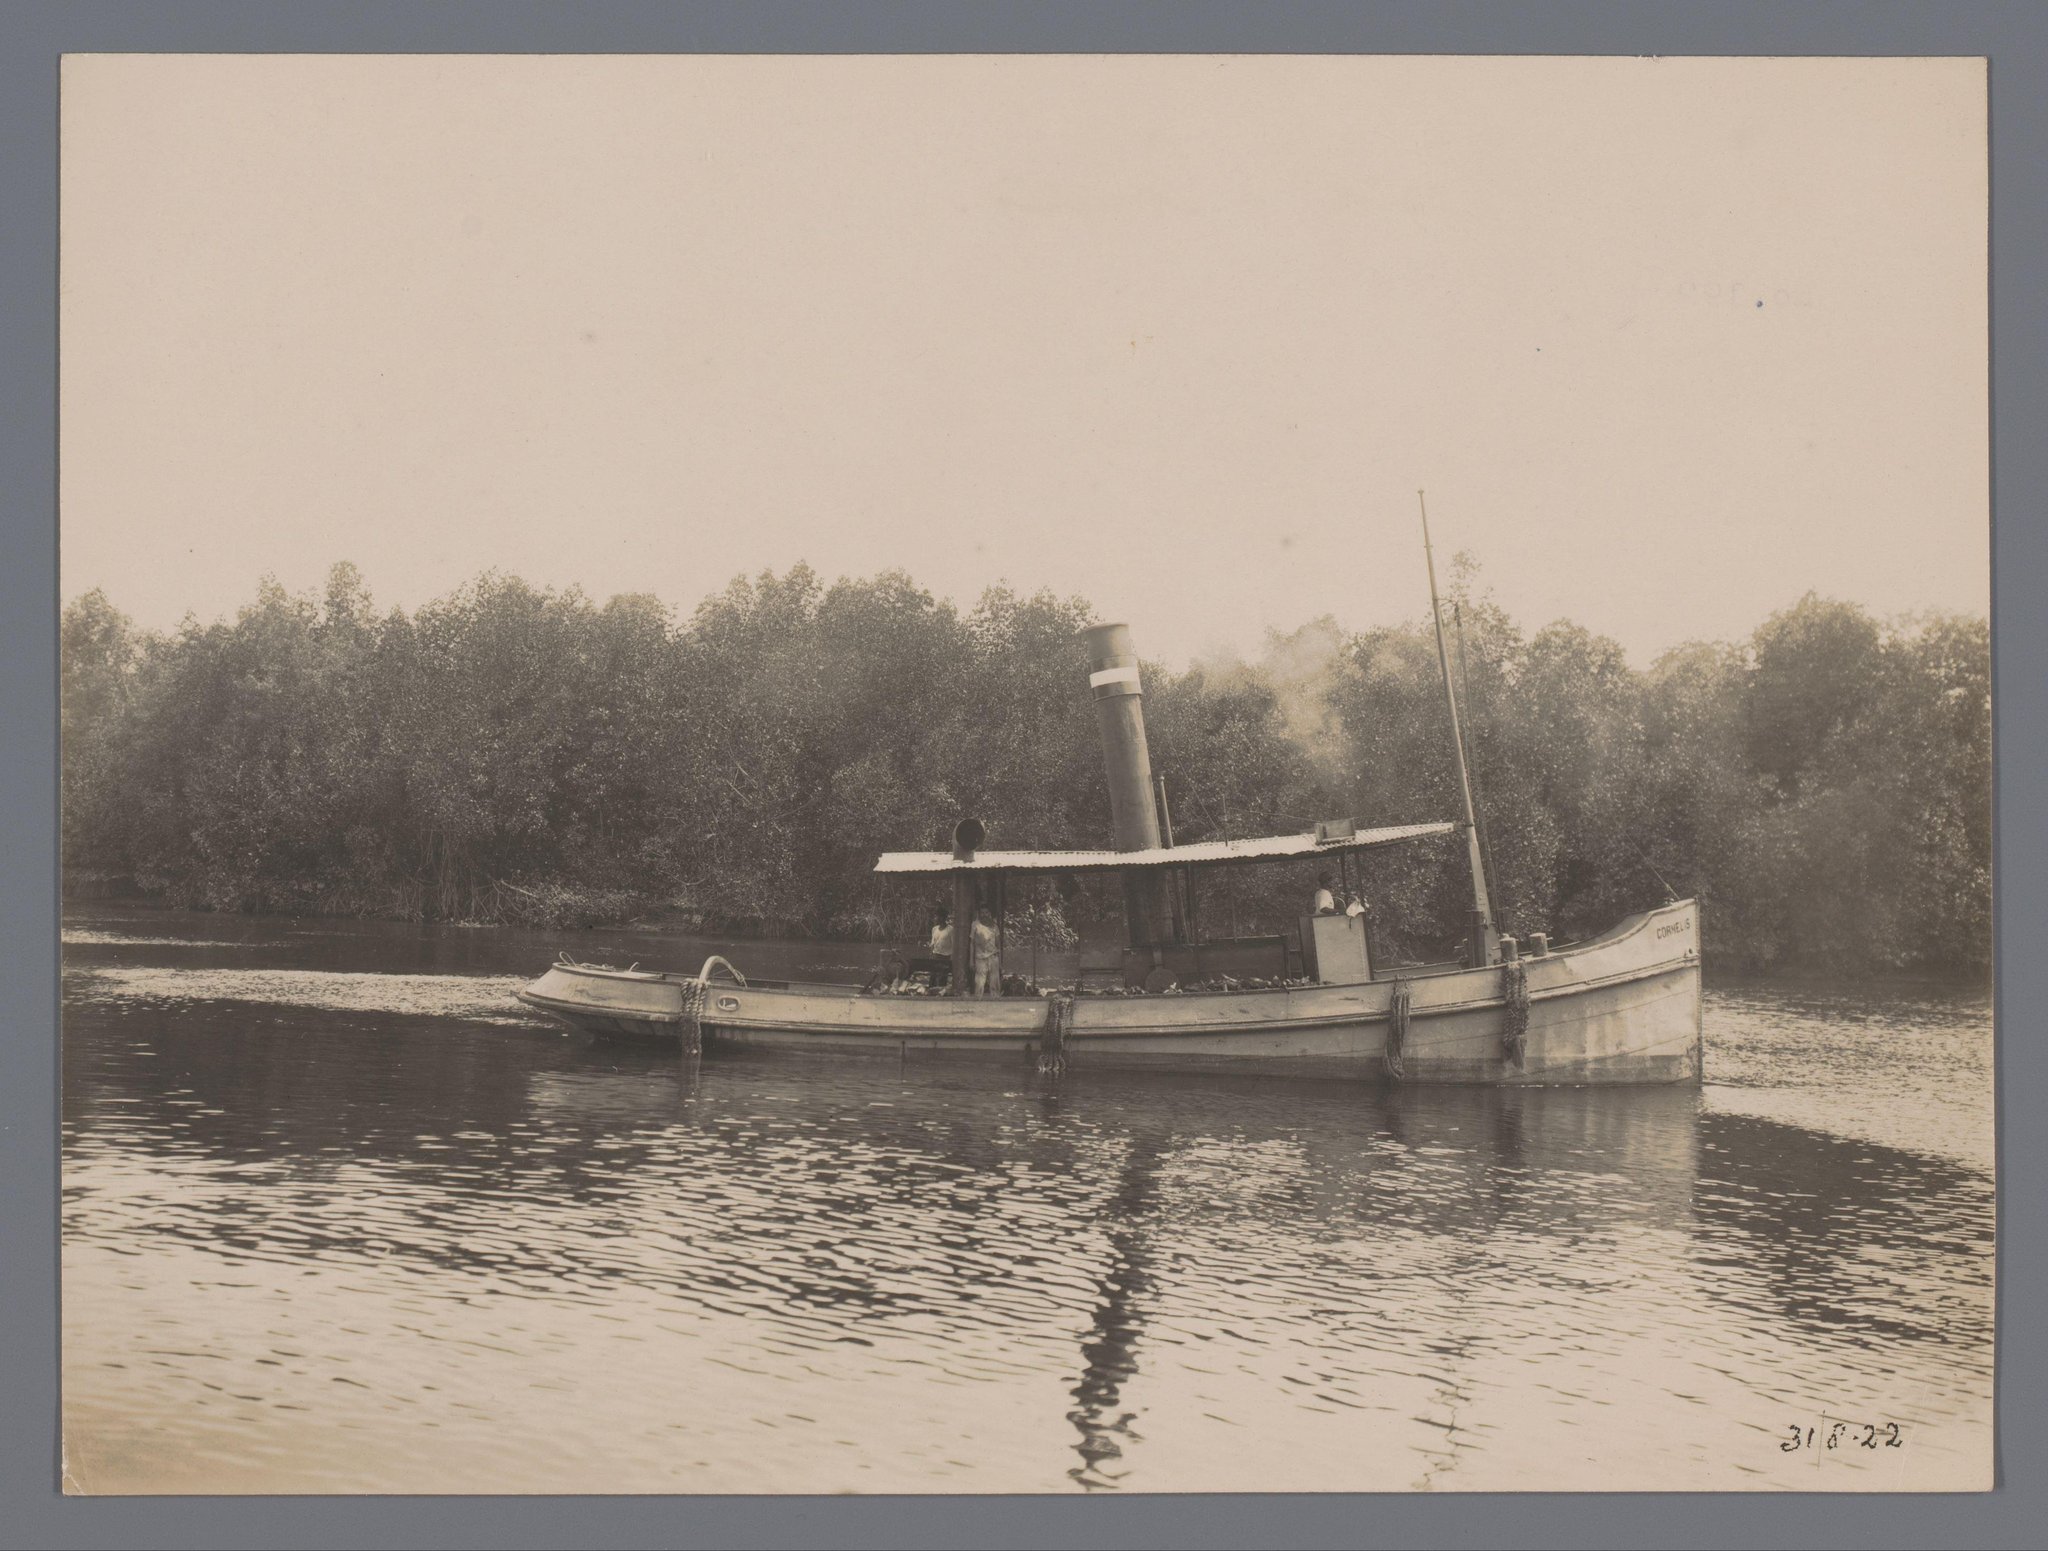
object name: photograph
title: Oceaanhaven Belawan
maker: Anonymous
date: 1922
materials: photographic support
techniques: gelatin silver print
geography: belawan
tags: harbour, building-site, tug, pusher tug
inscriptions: date: ‘31/8-22’, inscription: ‘No. 191 / Sleepboot "Cornelis"’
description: De sleepboot 'Cornelis'. Genummerd: 192. Onderdeel van de groep van losse foto's over de aanleg van de haven Belawan aan de kust voor Medan, Sumatra 1921-1922.